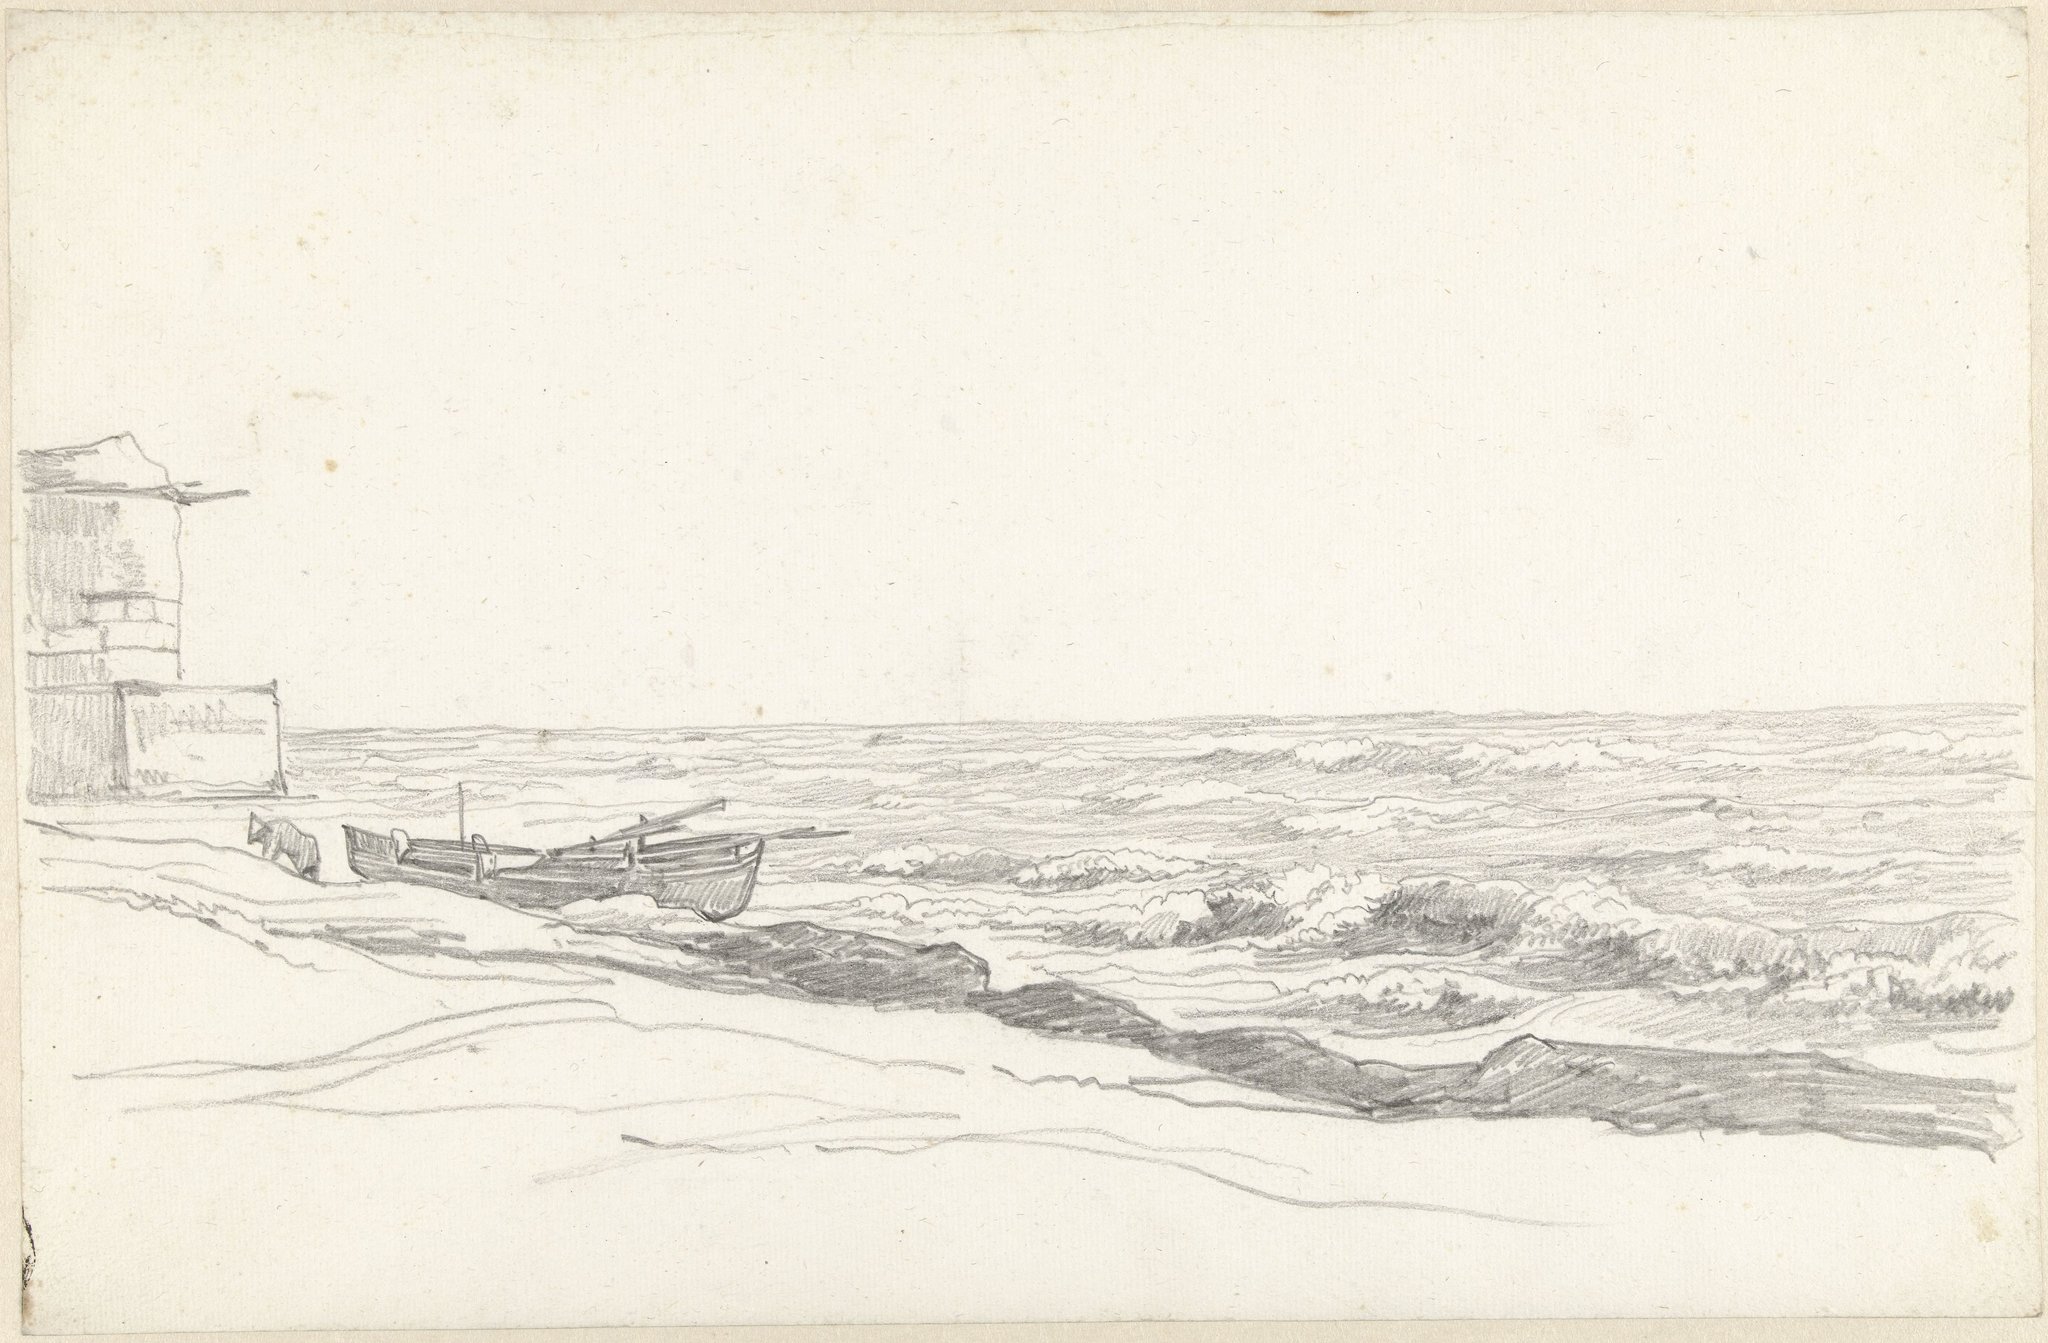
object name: drawing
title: Kustgezicht met bolwerk en op het strand getrokken boot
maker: hendrik voogd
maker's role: draughtsman, painter, print maker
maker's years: 1768-1839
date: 1788-1839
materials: paper, pencil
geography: rome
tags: beach